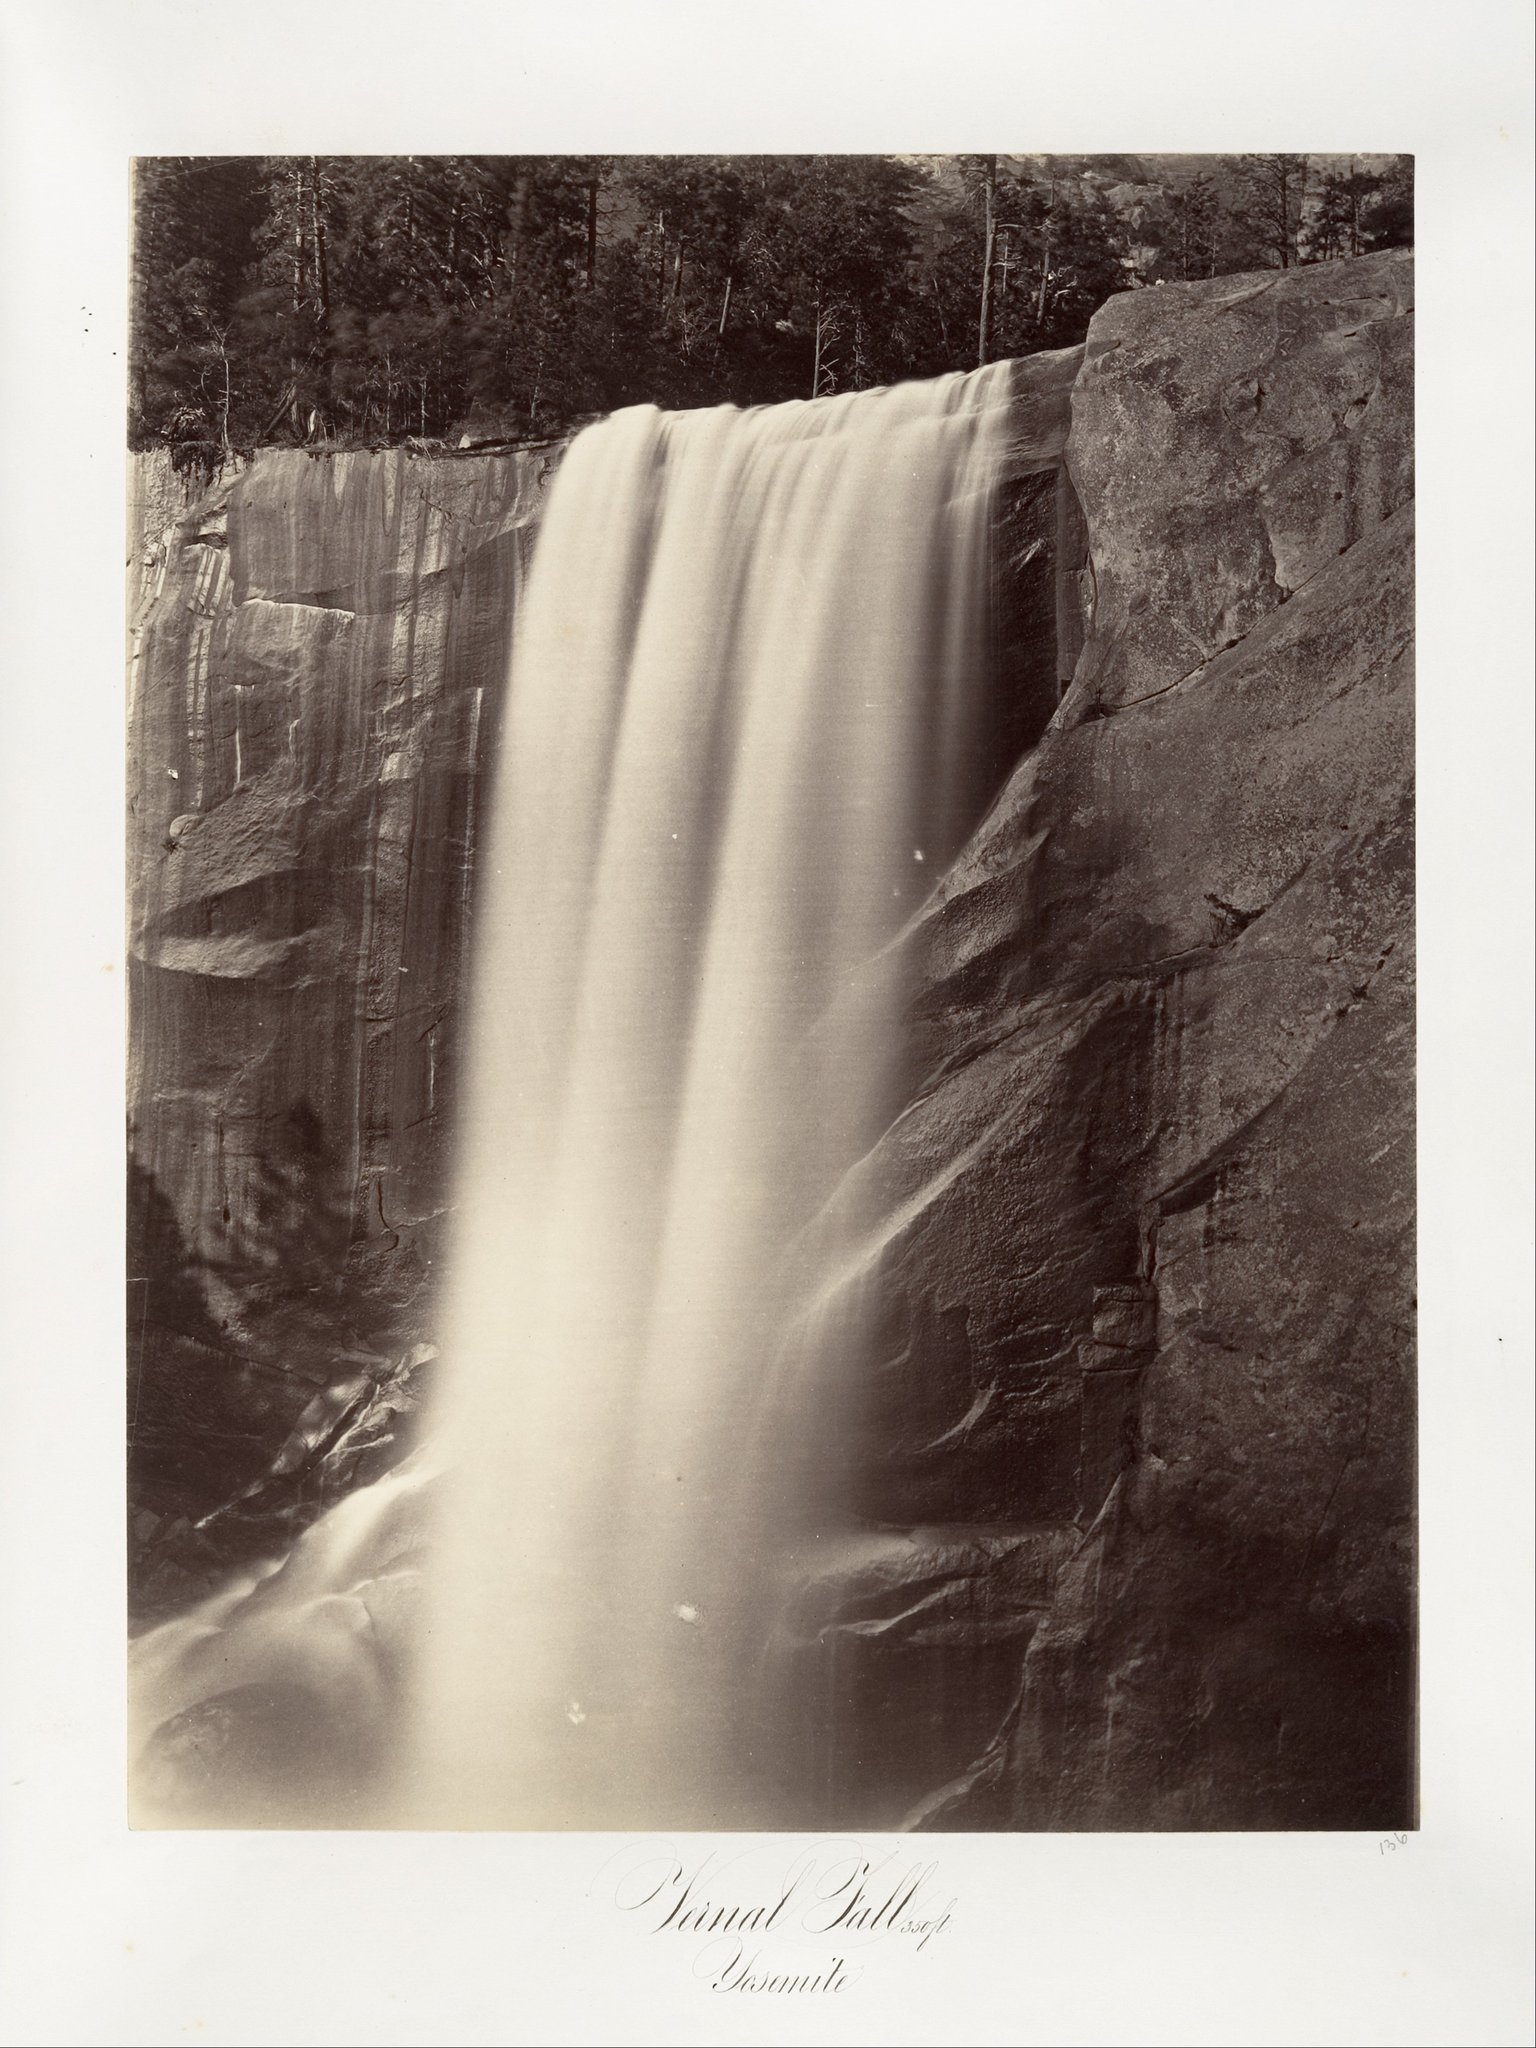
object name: photograph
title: Vernal Falls, 350 feet, Yosemite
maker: carleton e. watkins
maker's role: artist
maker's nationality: american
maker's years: 1829-1916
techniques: albumen silver print, glass negative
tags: waterfalls